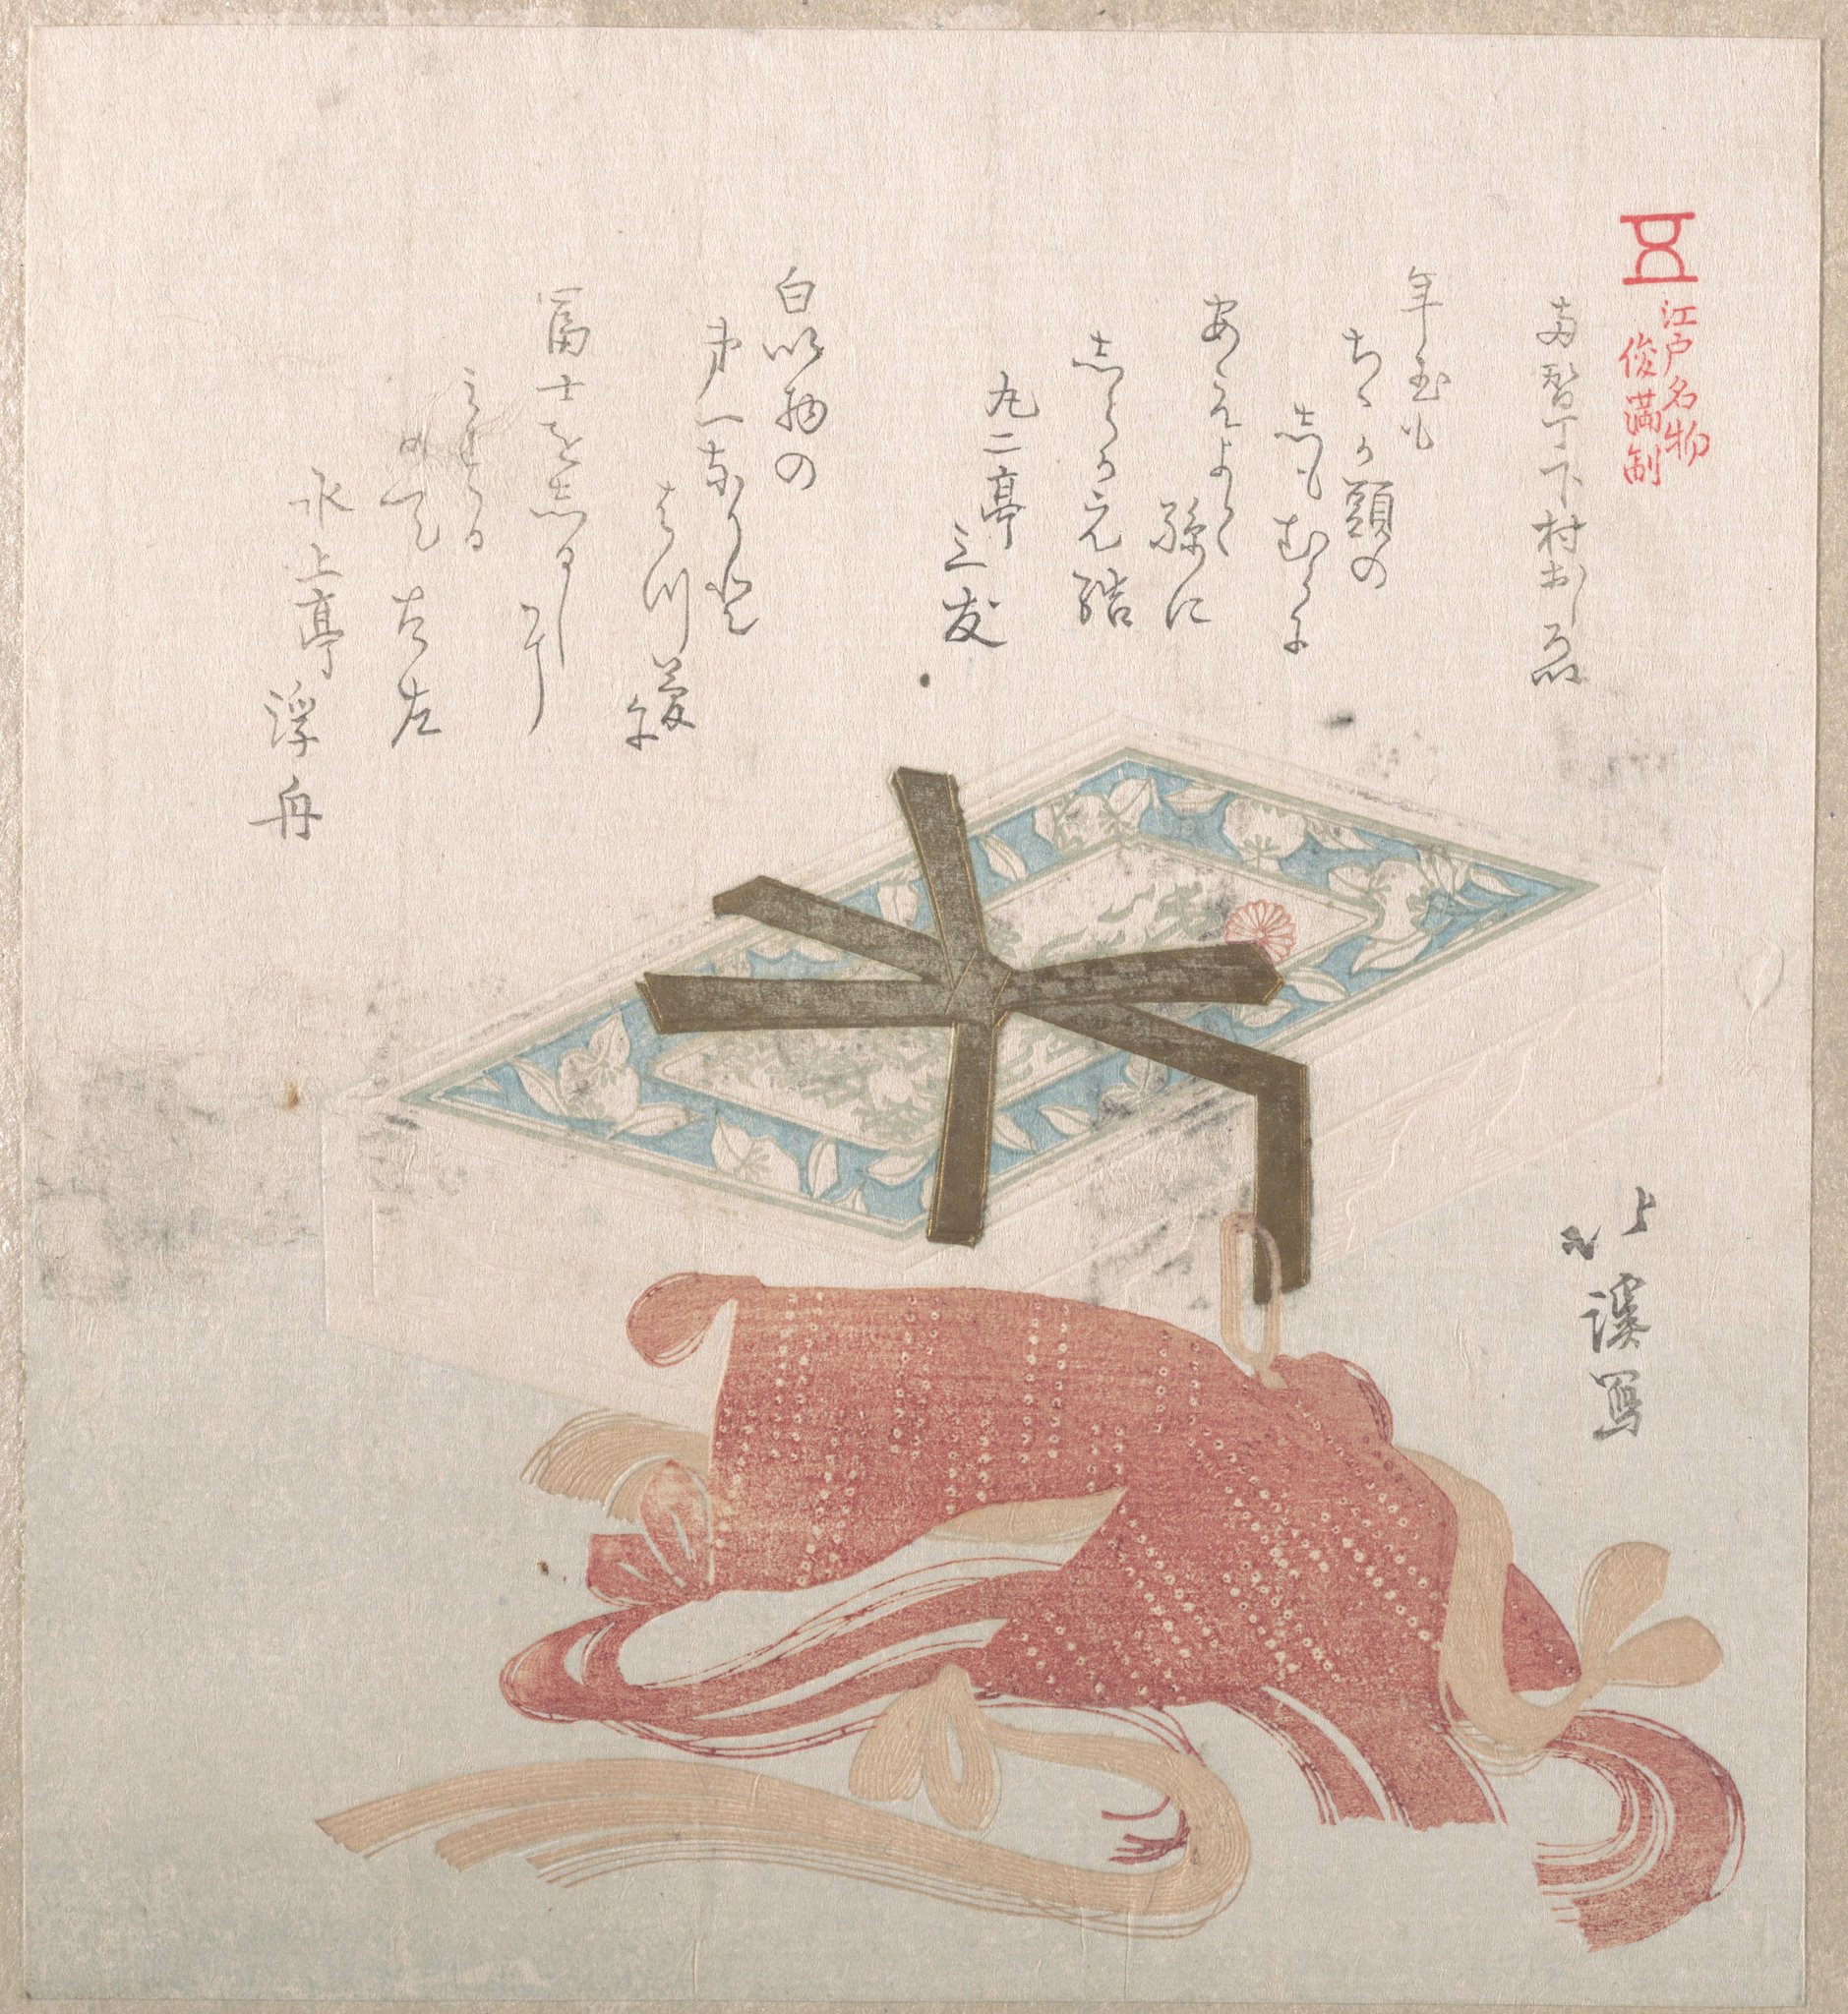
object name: woodblock print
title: Box of Face Powder and Hair Ties; Specialities of Shimomura in Ryogaecho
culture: japanese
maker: totoya hokkei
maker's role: artist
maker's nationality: japanese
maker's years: 1780-1850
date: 1801-1900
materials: ink, paper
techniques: surimono, woodblock print